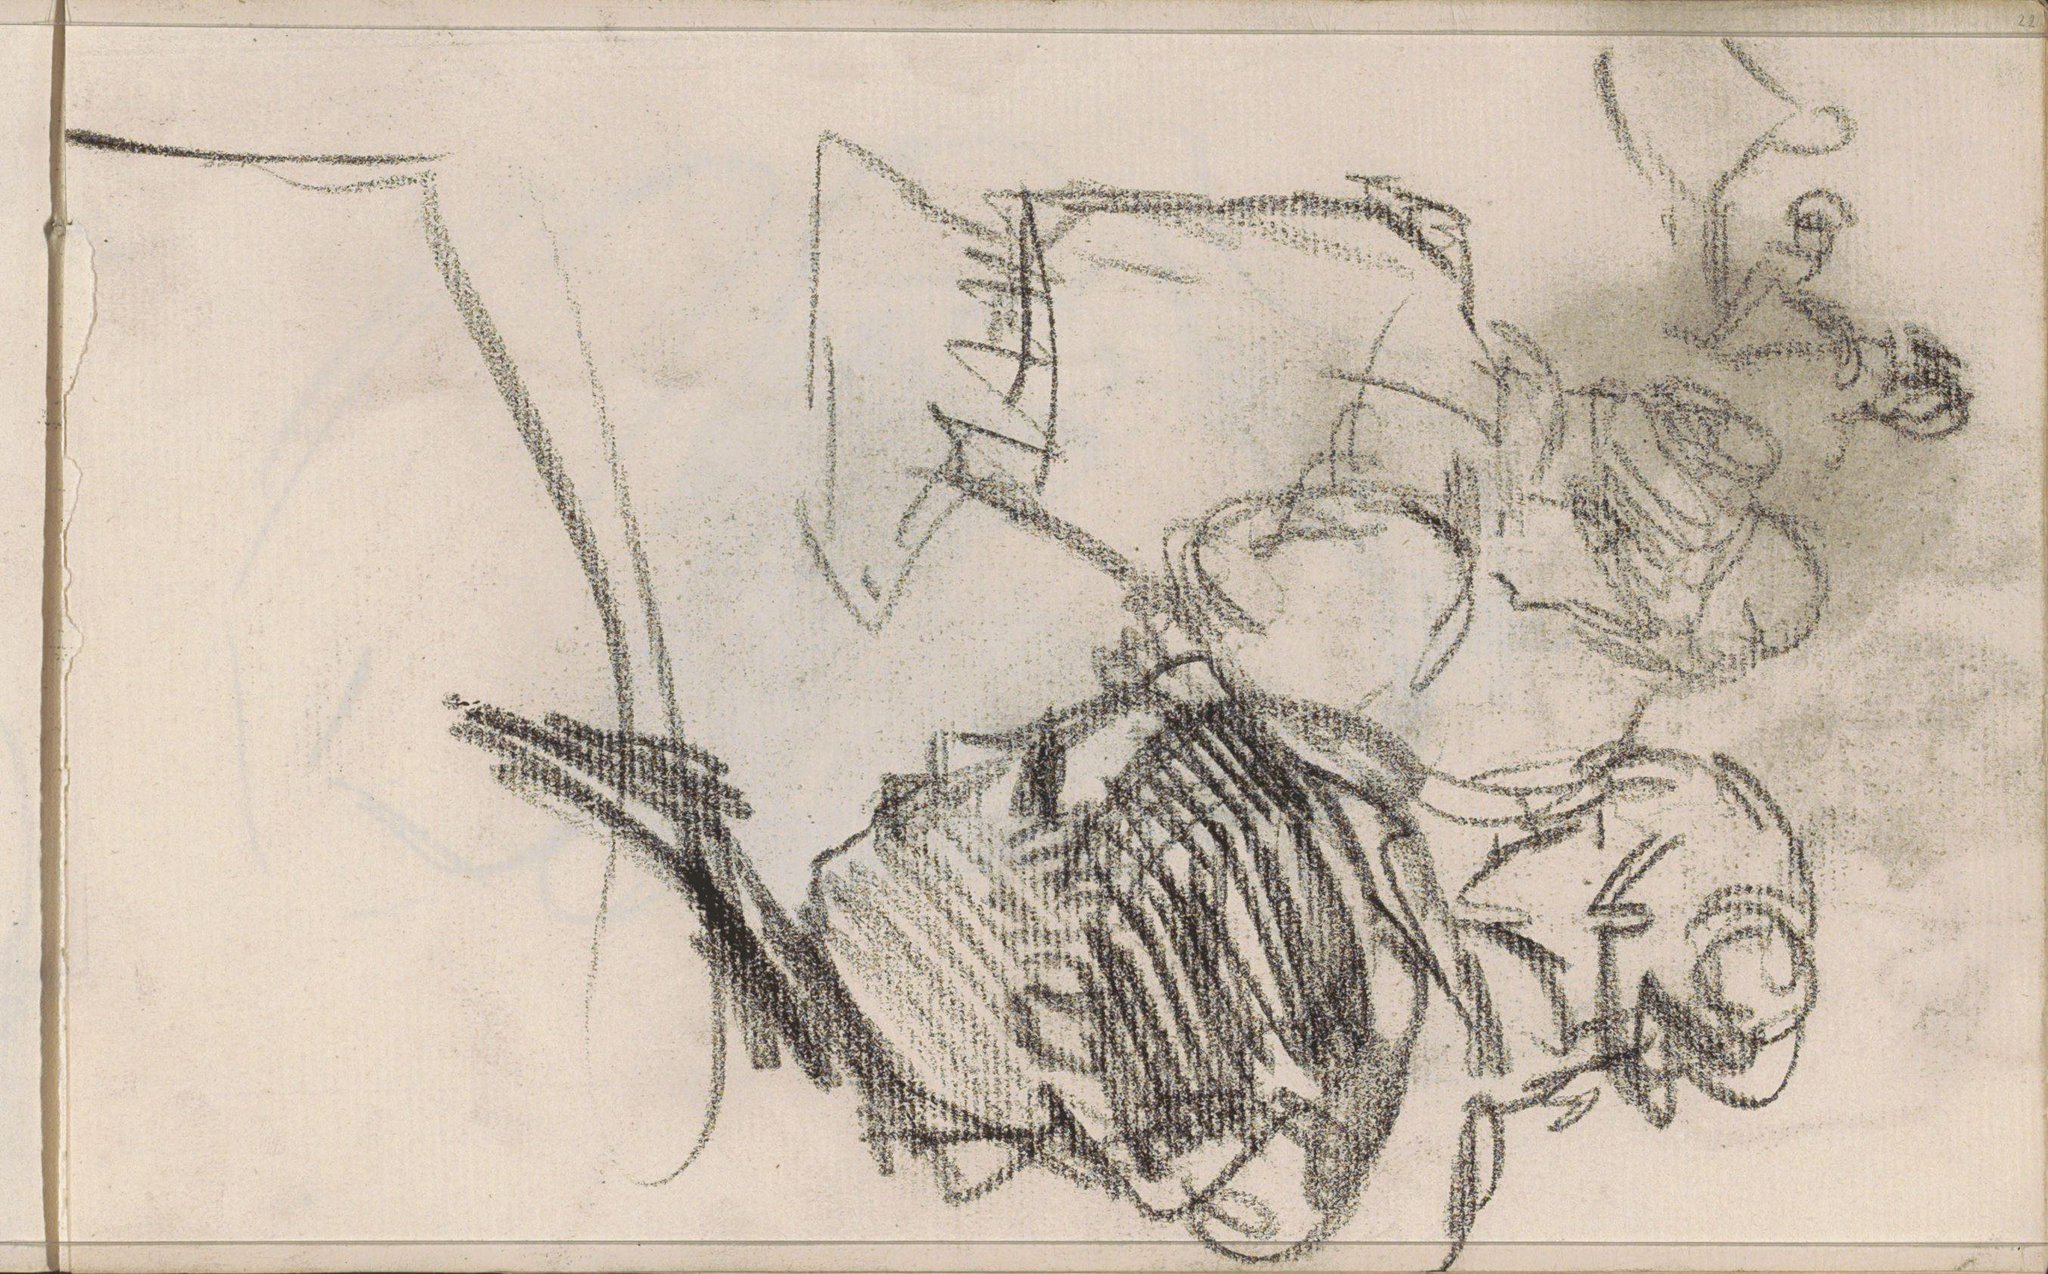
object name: sketchbook leaf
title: Studieblad met vrouwen, mogelijk koffiepiksters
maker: isaac israels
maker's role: draughtsman, painter, print maker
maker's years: 1865-1934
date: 1886-1903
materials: chalk, paper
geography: amsterdam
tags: adult woman (+ sitting), working class, labourers - aa - women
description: Pagina 22 uit schetsboek XXXIII met 47 pagina's.